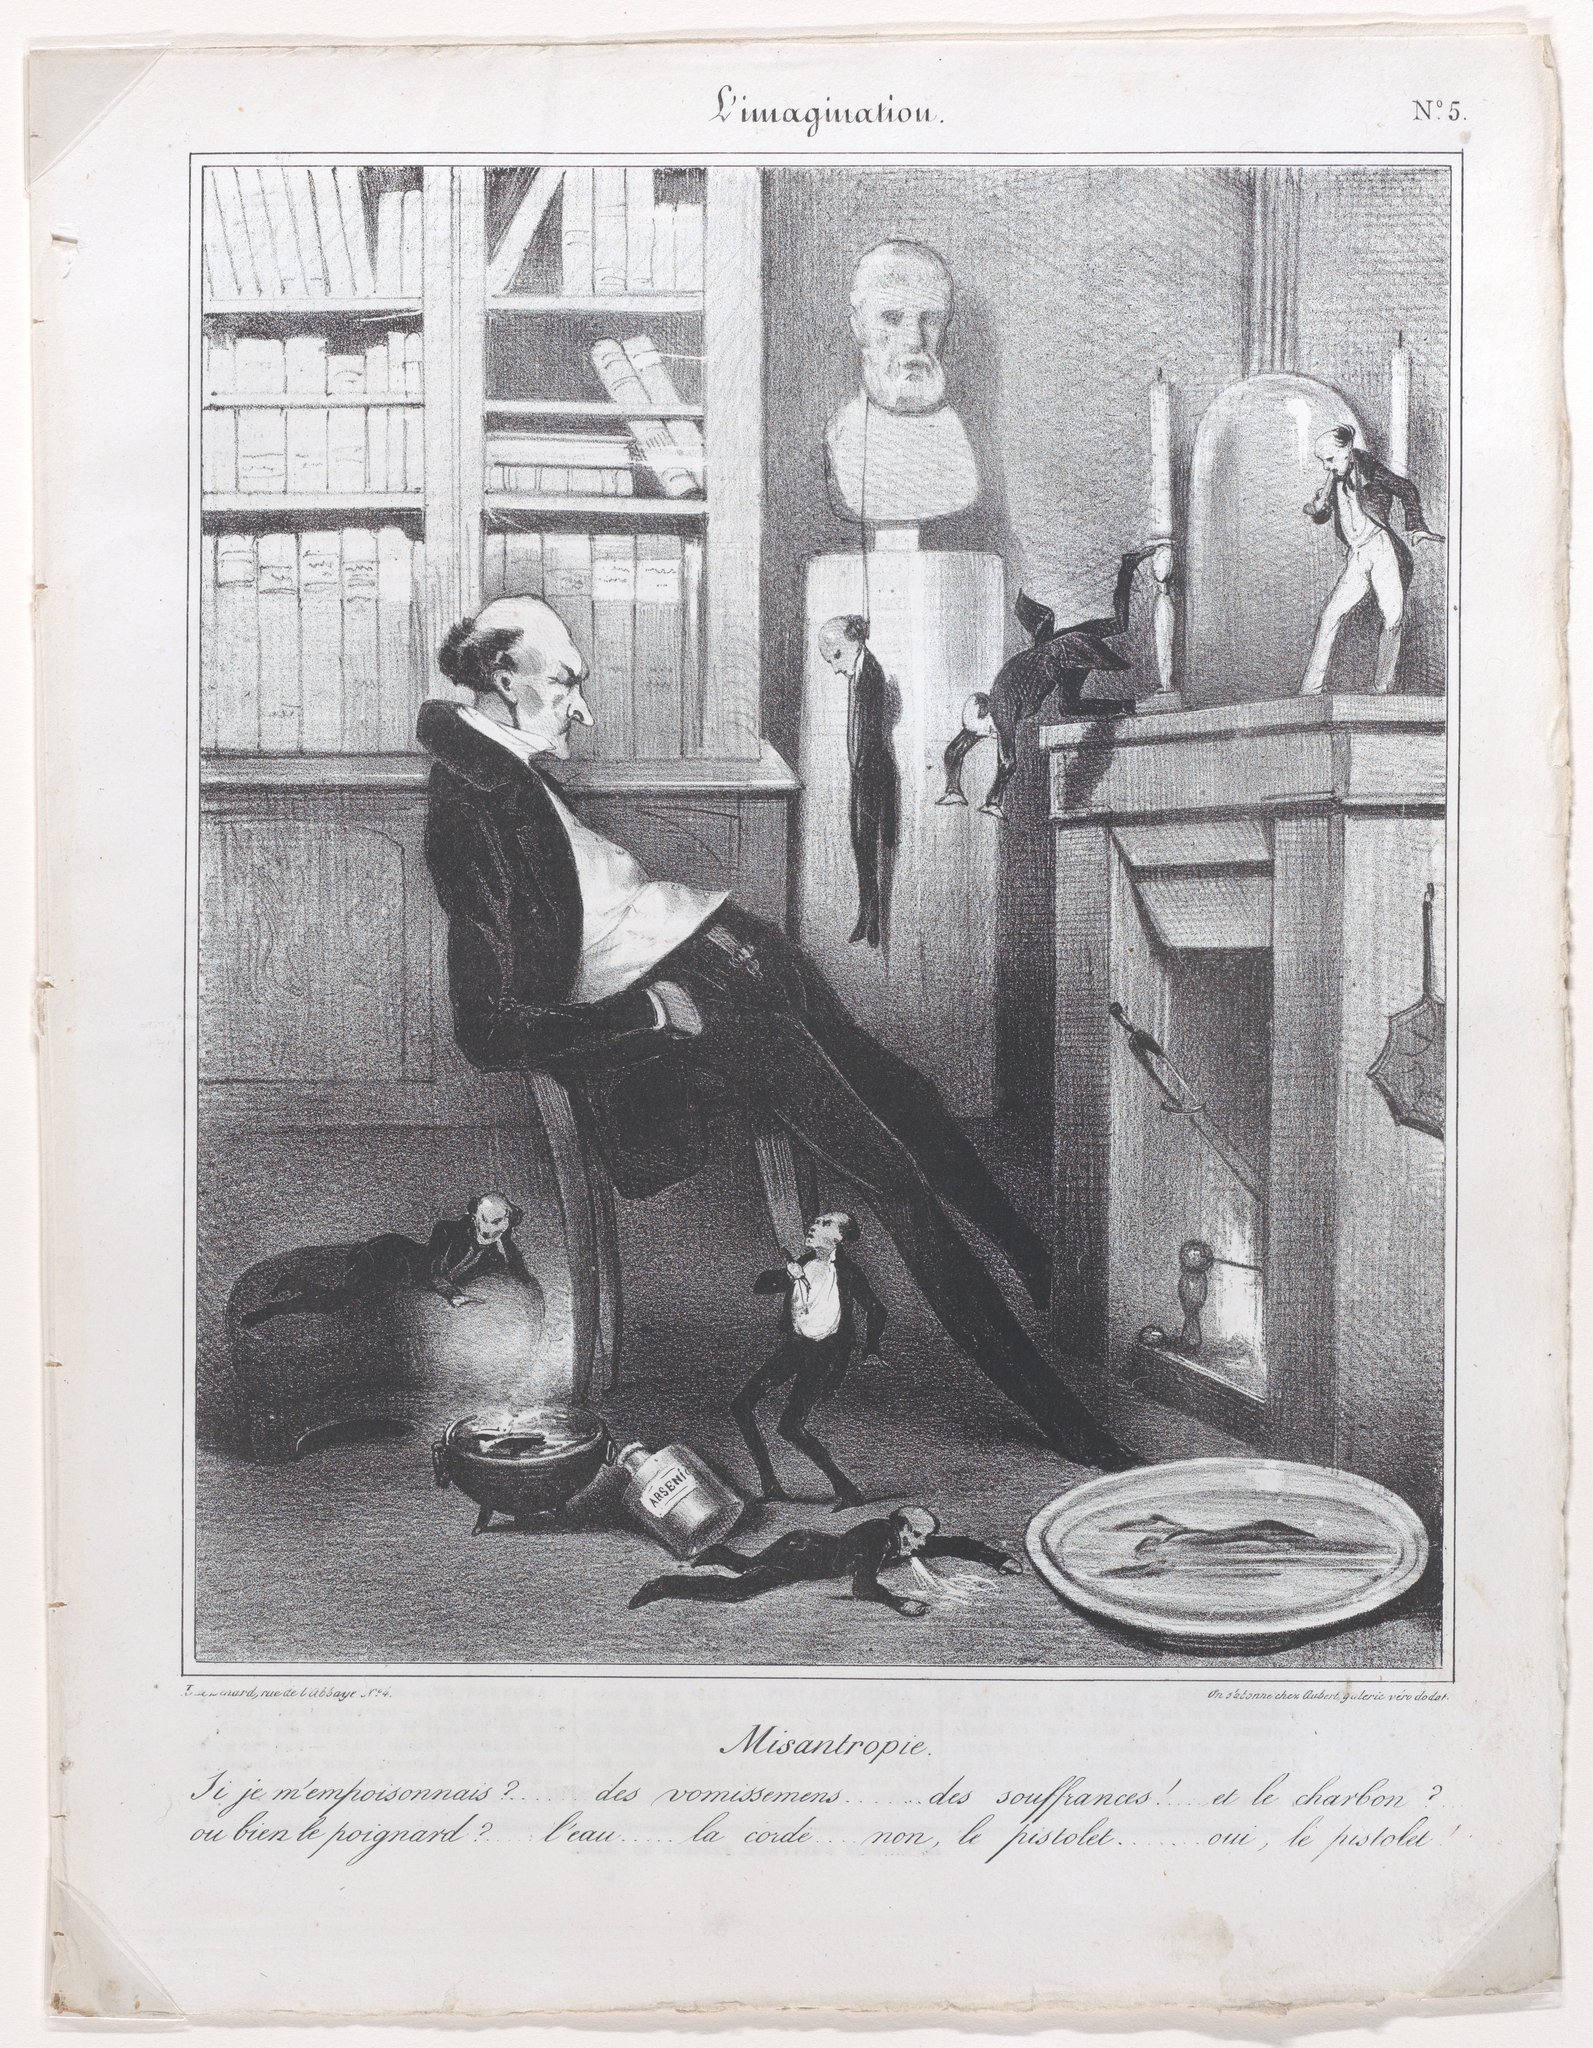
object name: print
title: The Misanthropist (Misantropie)..., from L'imagination, published in Le Charivari, February 10, 1833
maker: honoré daumier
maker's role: artist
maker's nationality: french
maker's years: 1808-1879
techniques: lithograph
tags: satire,men